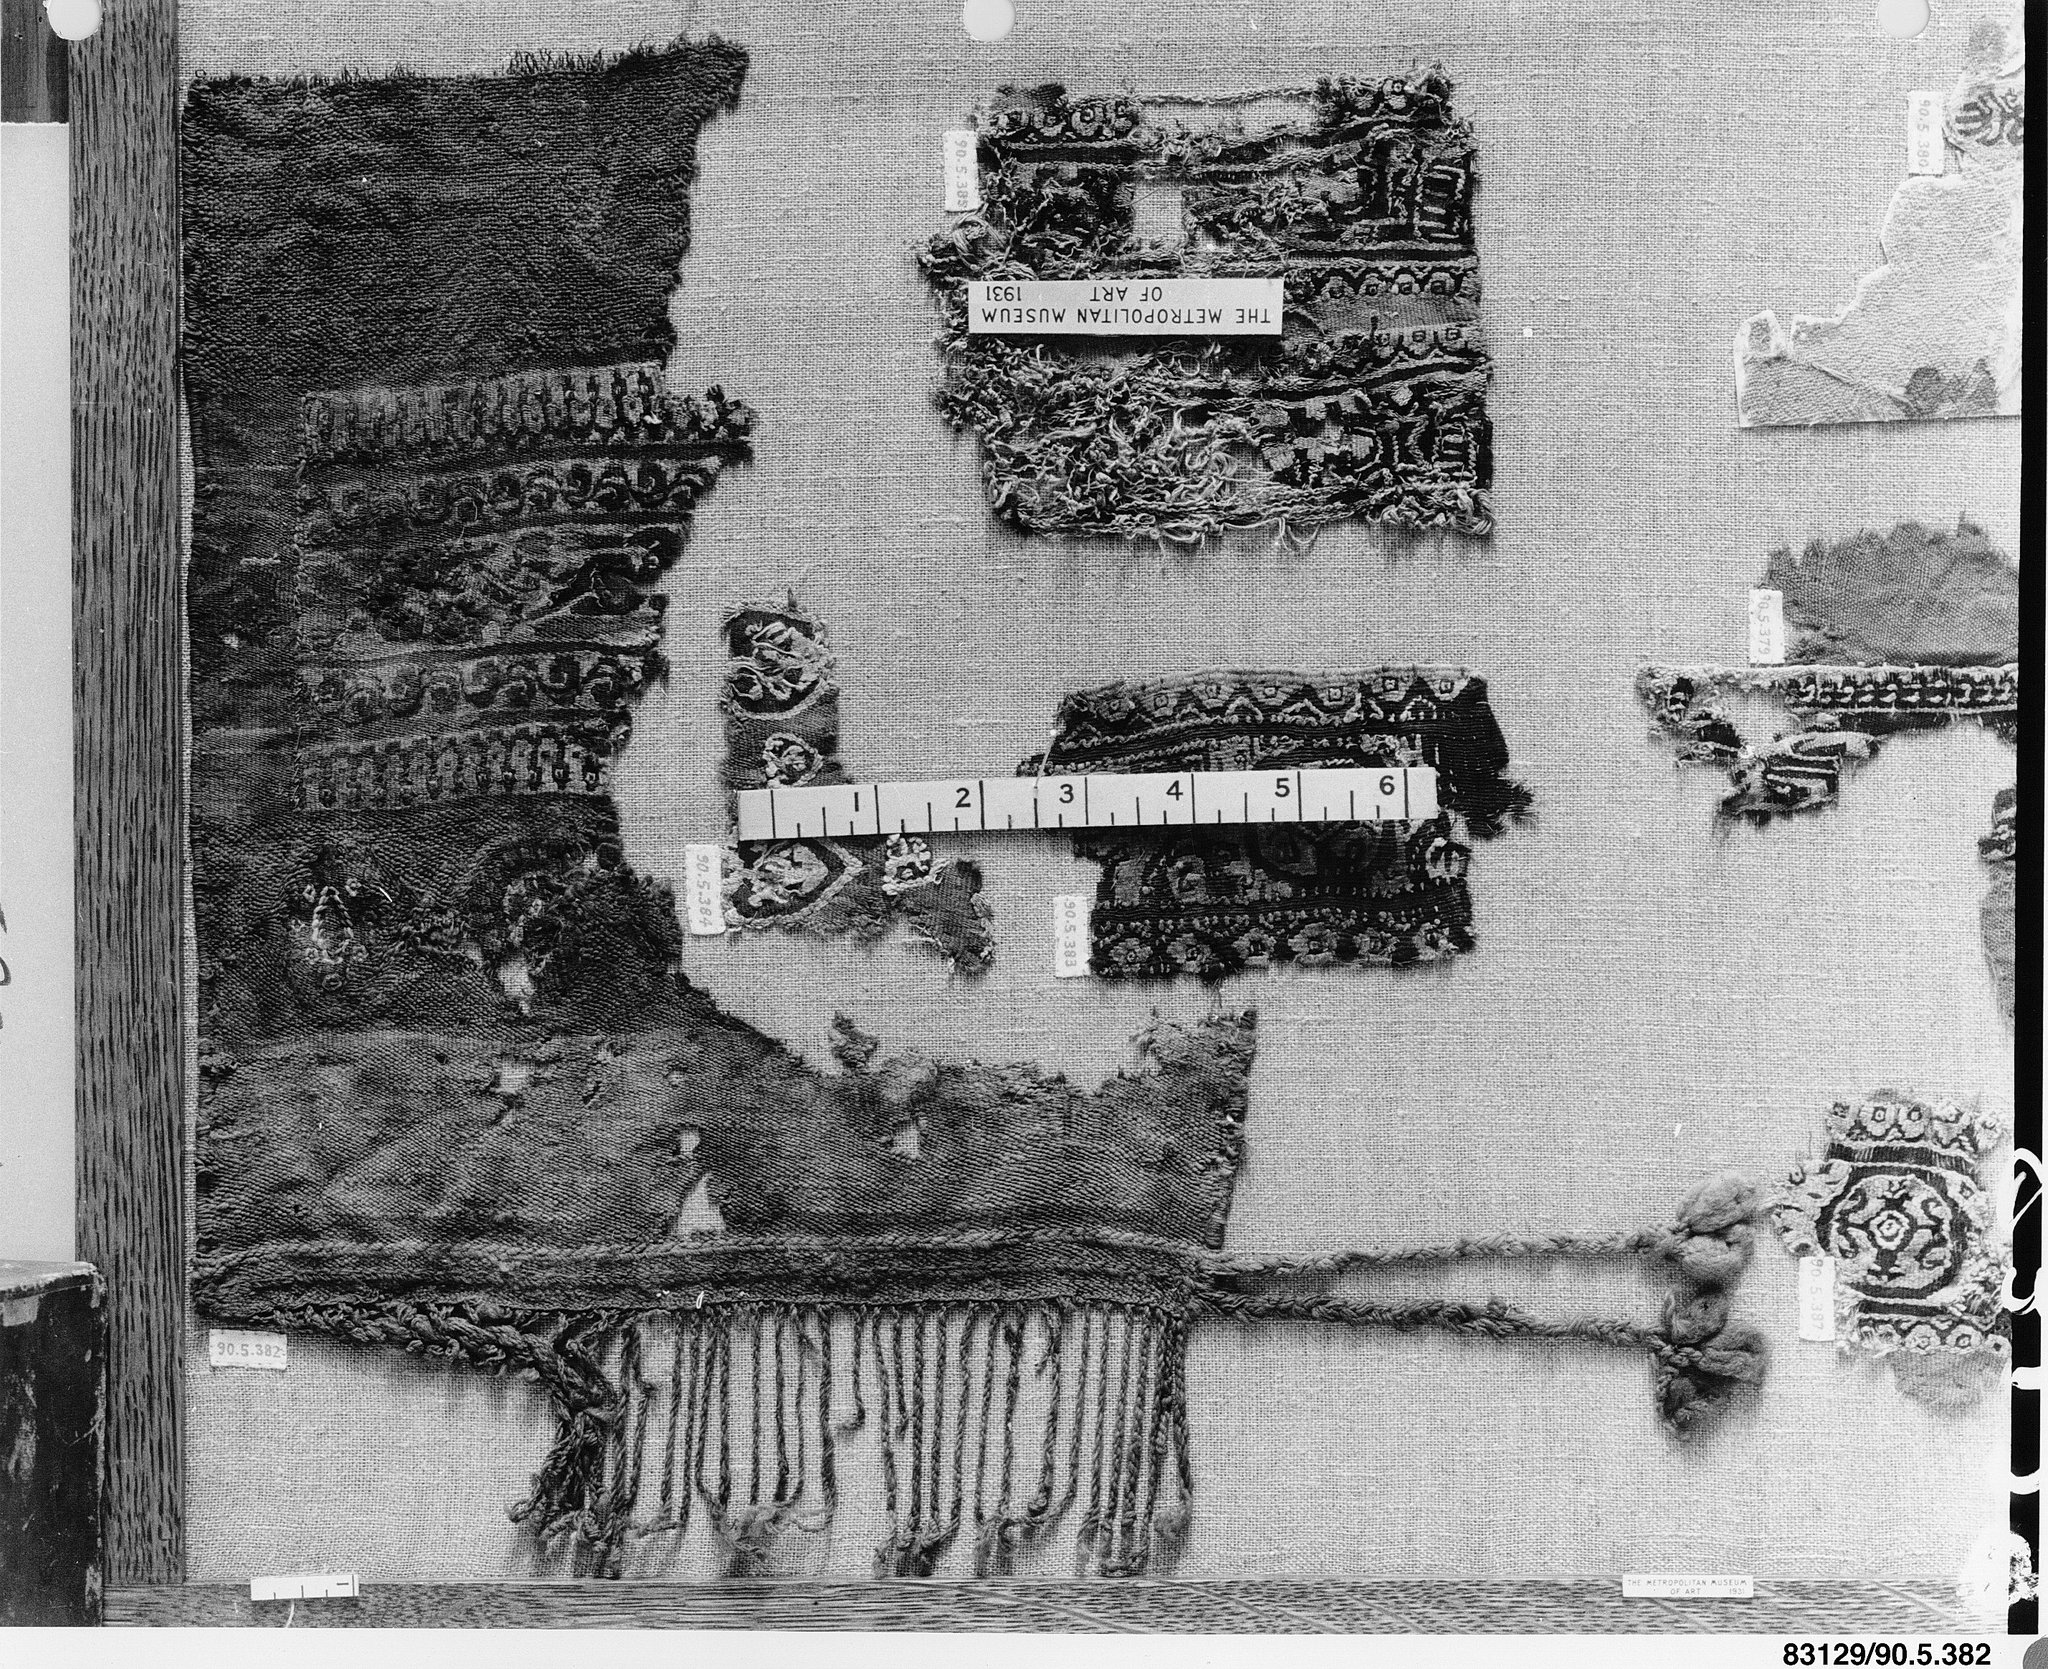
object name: textile fragment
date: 301-400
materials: linen, wool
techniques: weave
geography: egypt